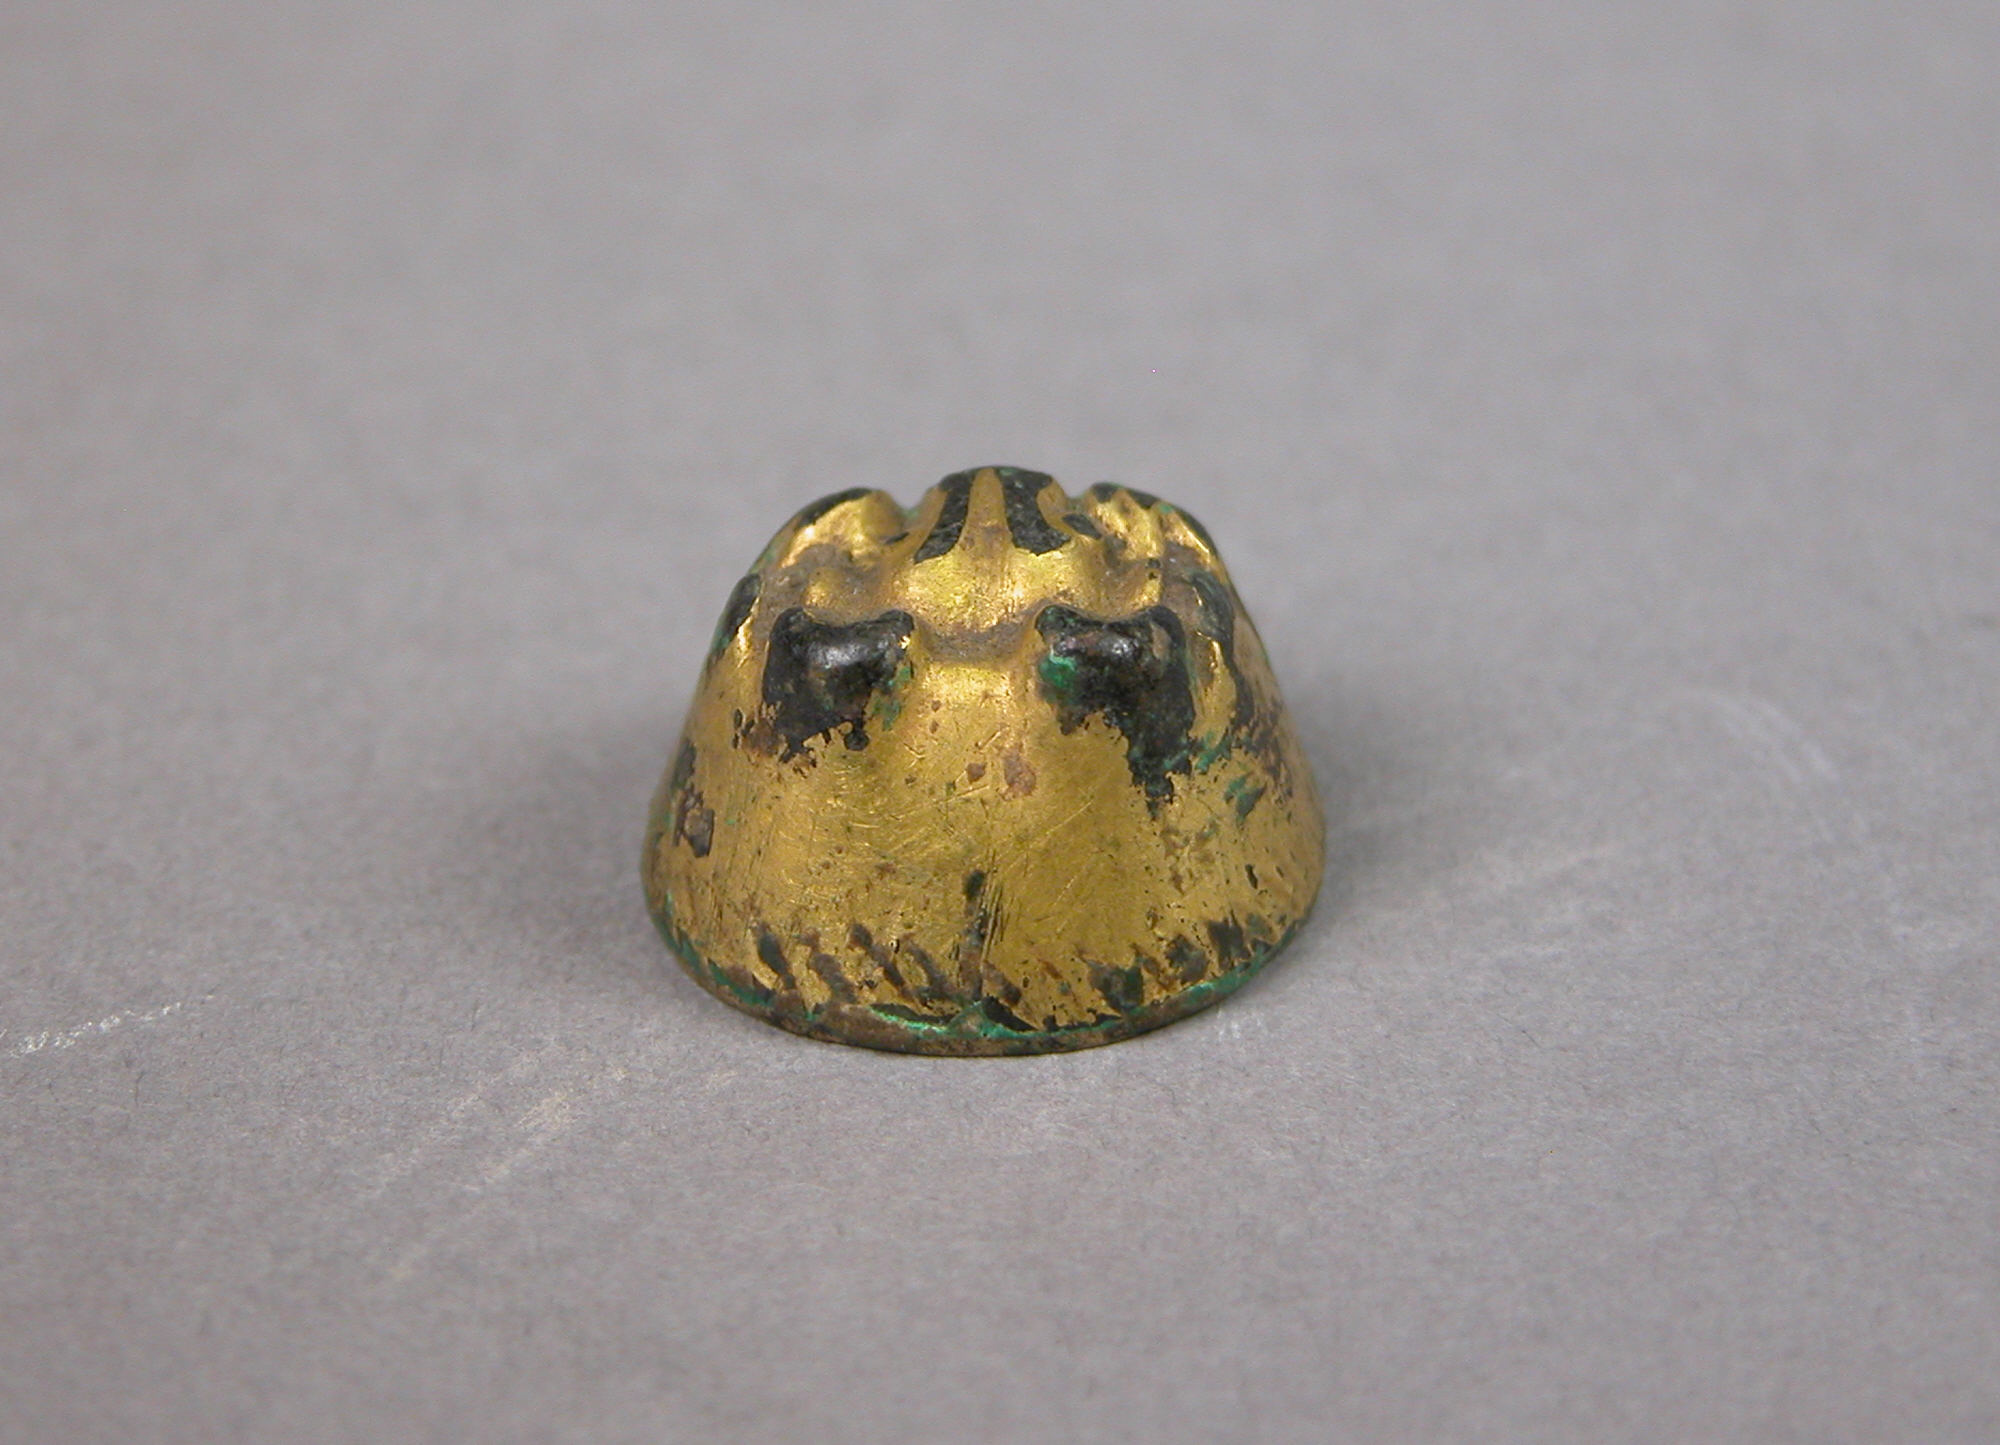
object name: ornament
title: Ornament in the shape of a bear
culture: chinese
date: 201-600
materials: gilt bronze